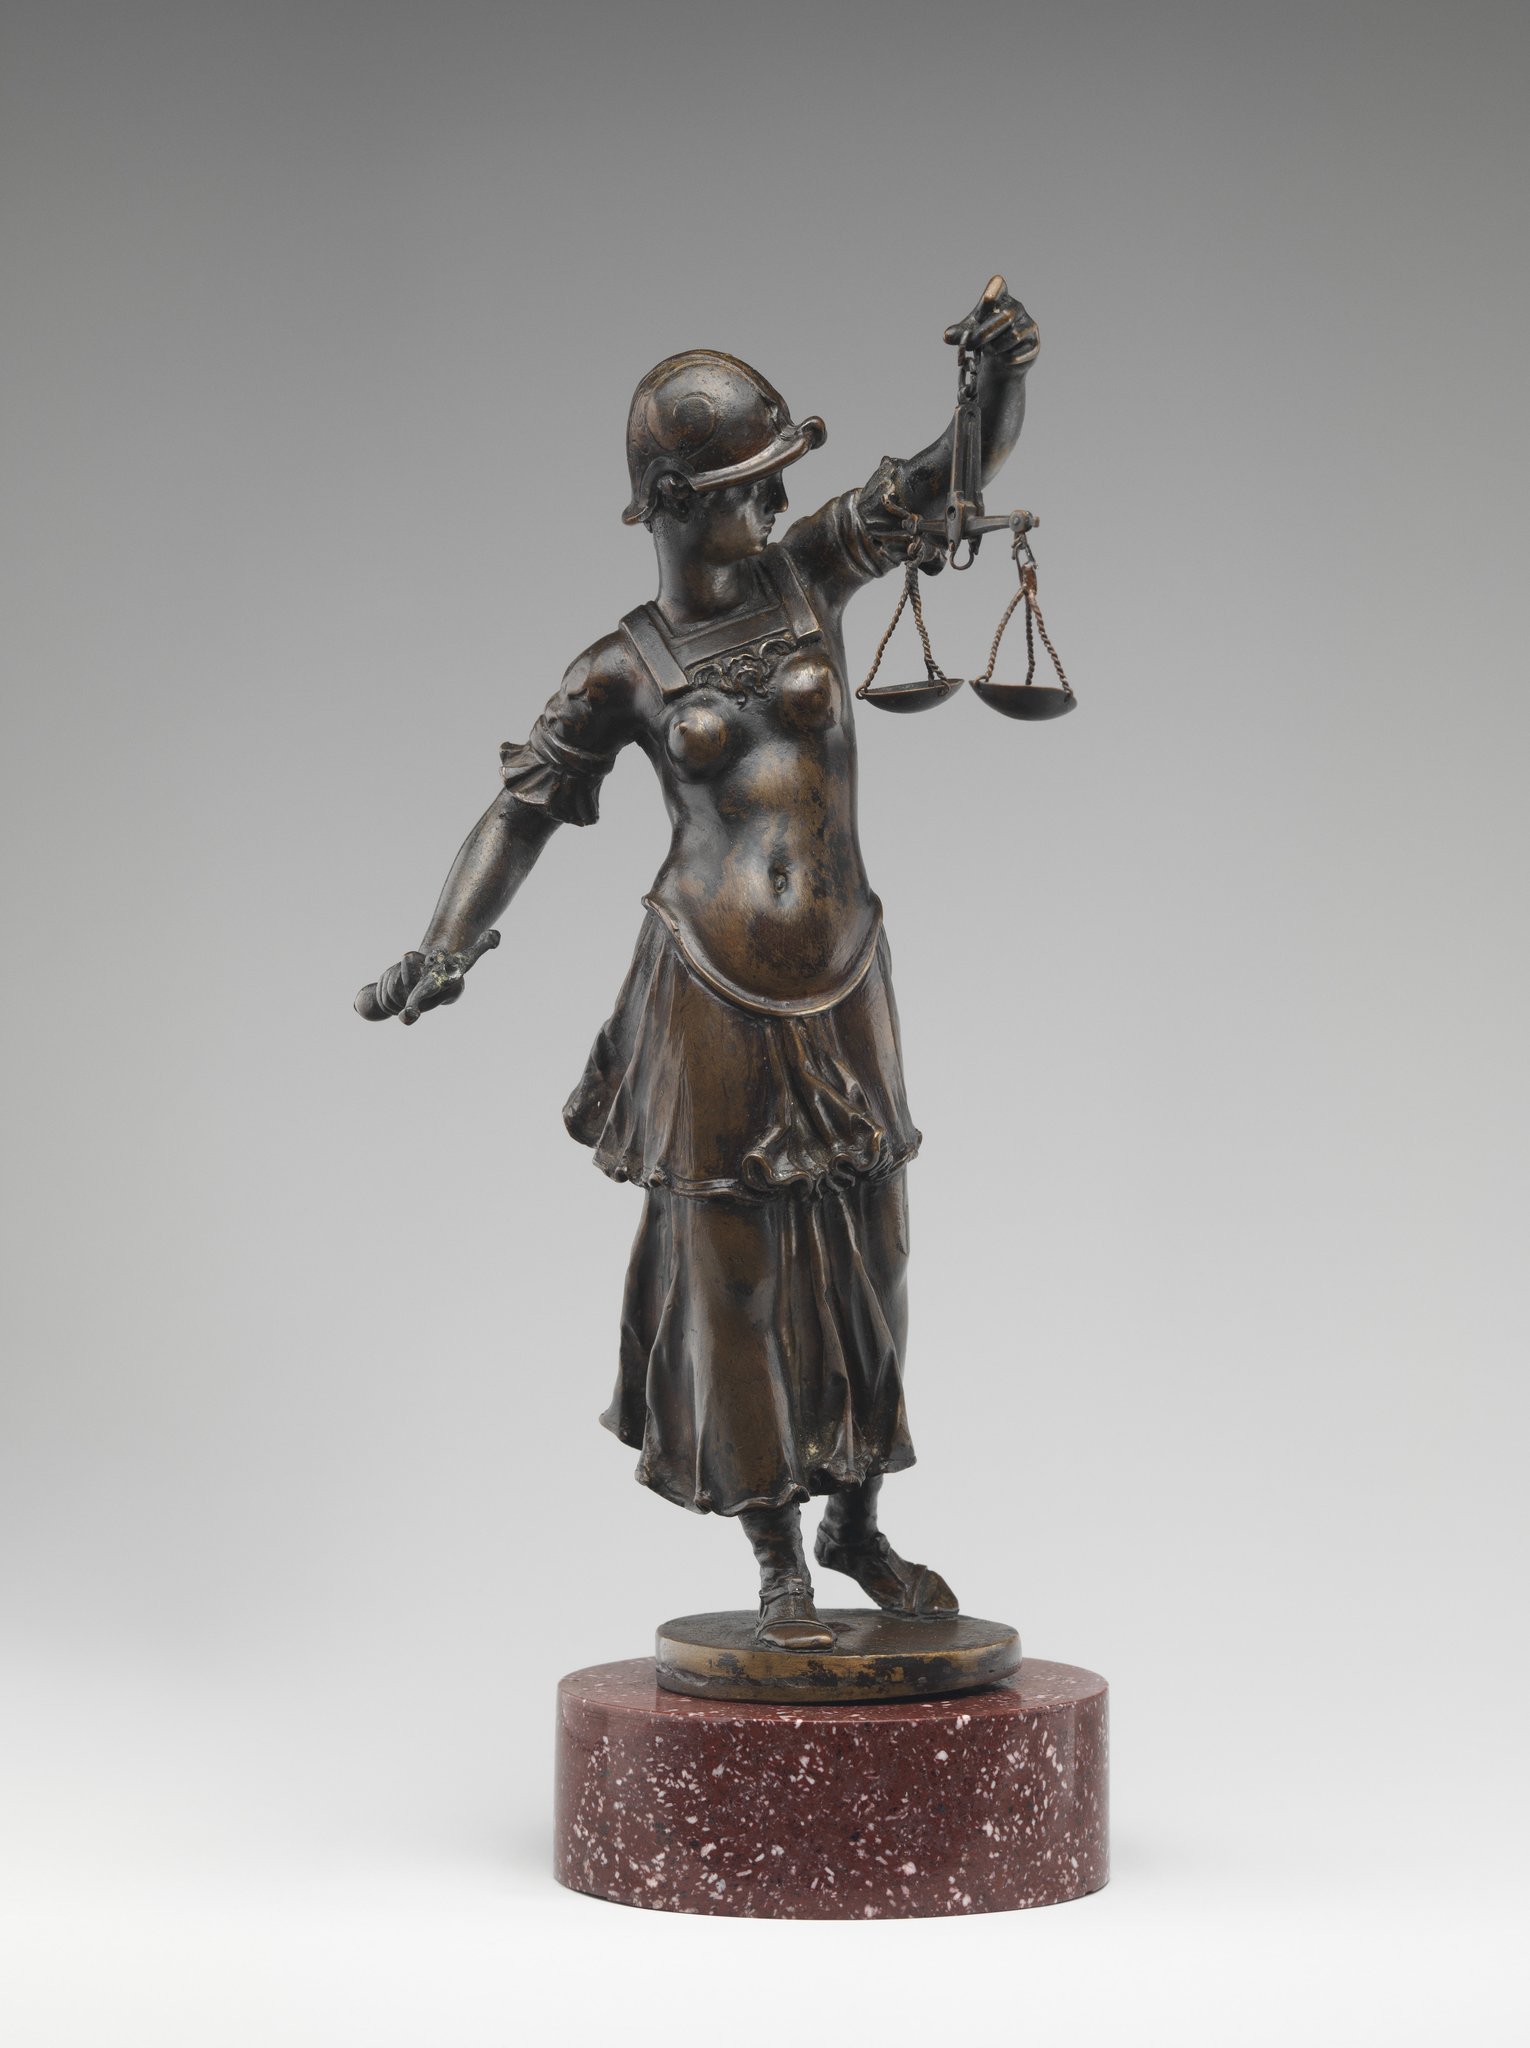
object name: statuette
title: Justice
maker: bartolomeo ammanati (ammannati)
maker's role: modeler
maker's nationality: italian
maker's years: 1511-1592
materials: bronze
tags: female nudes